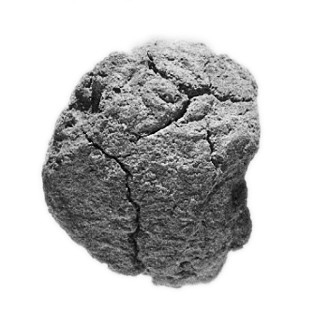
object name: sealing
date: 1981-1640 BCE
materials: mud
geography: egypt